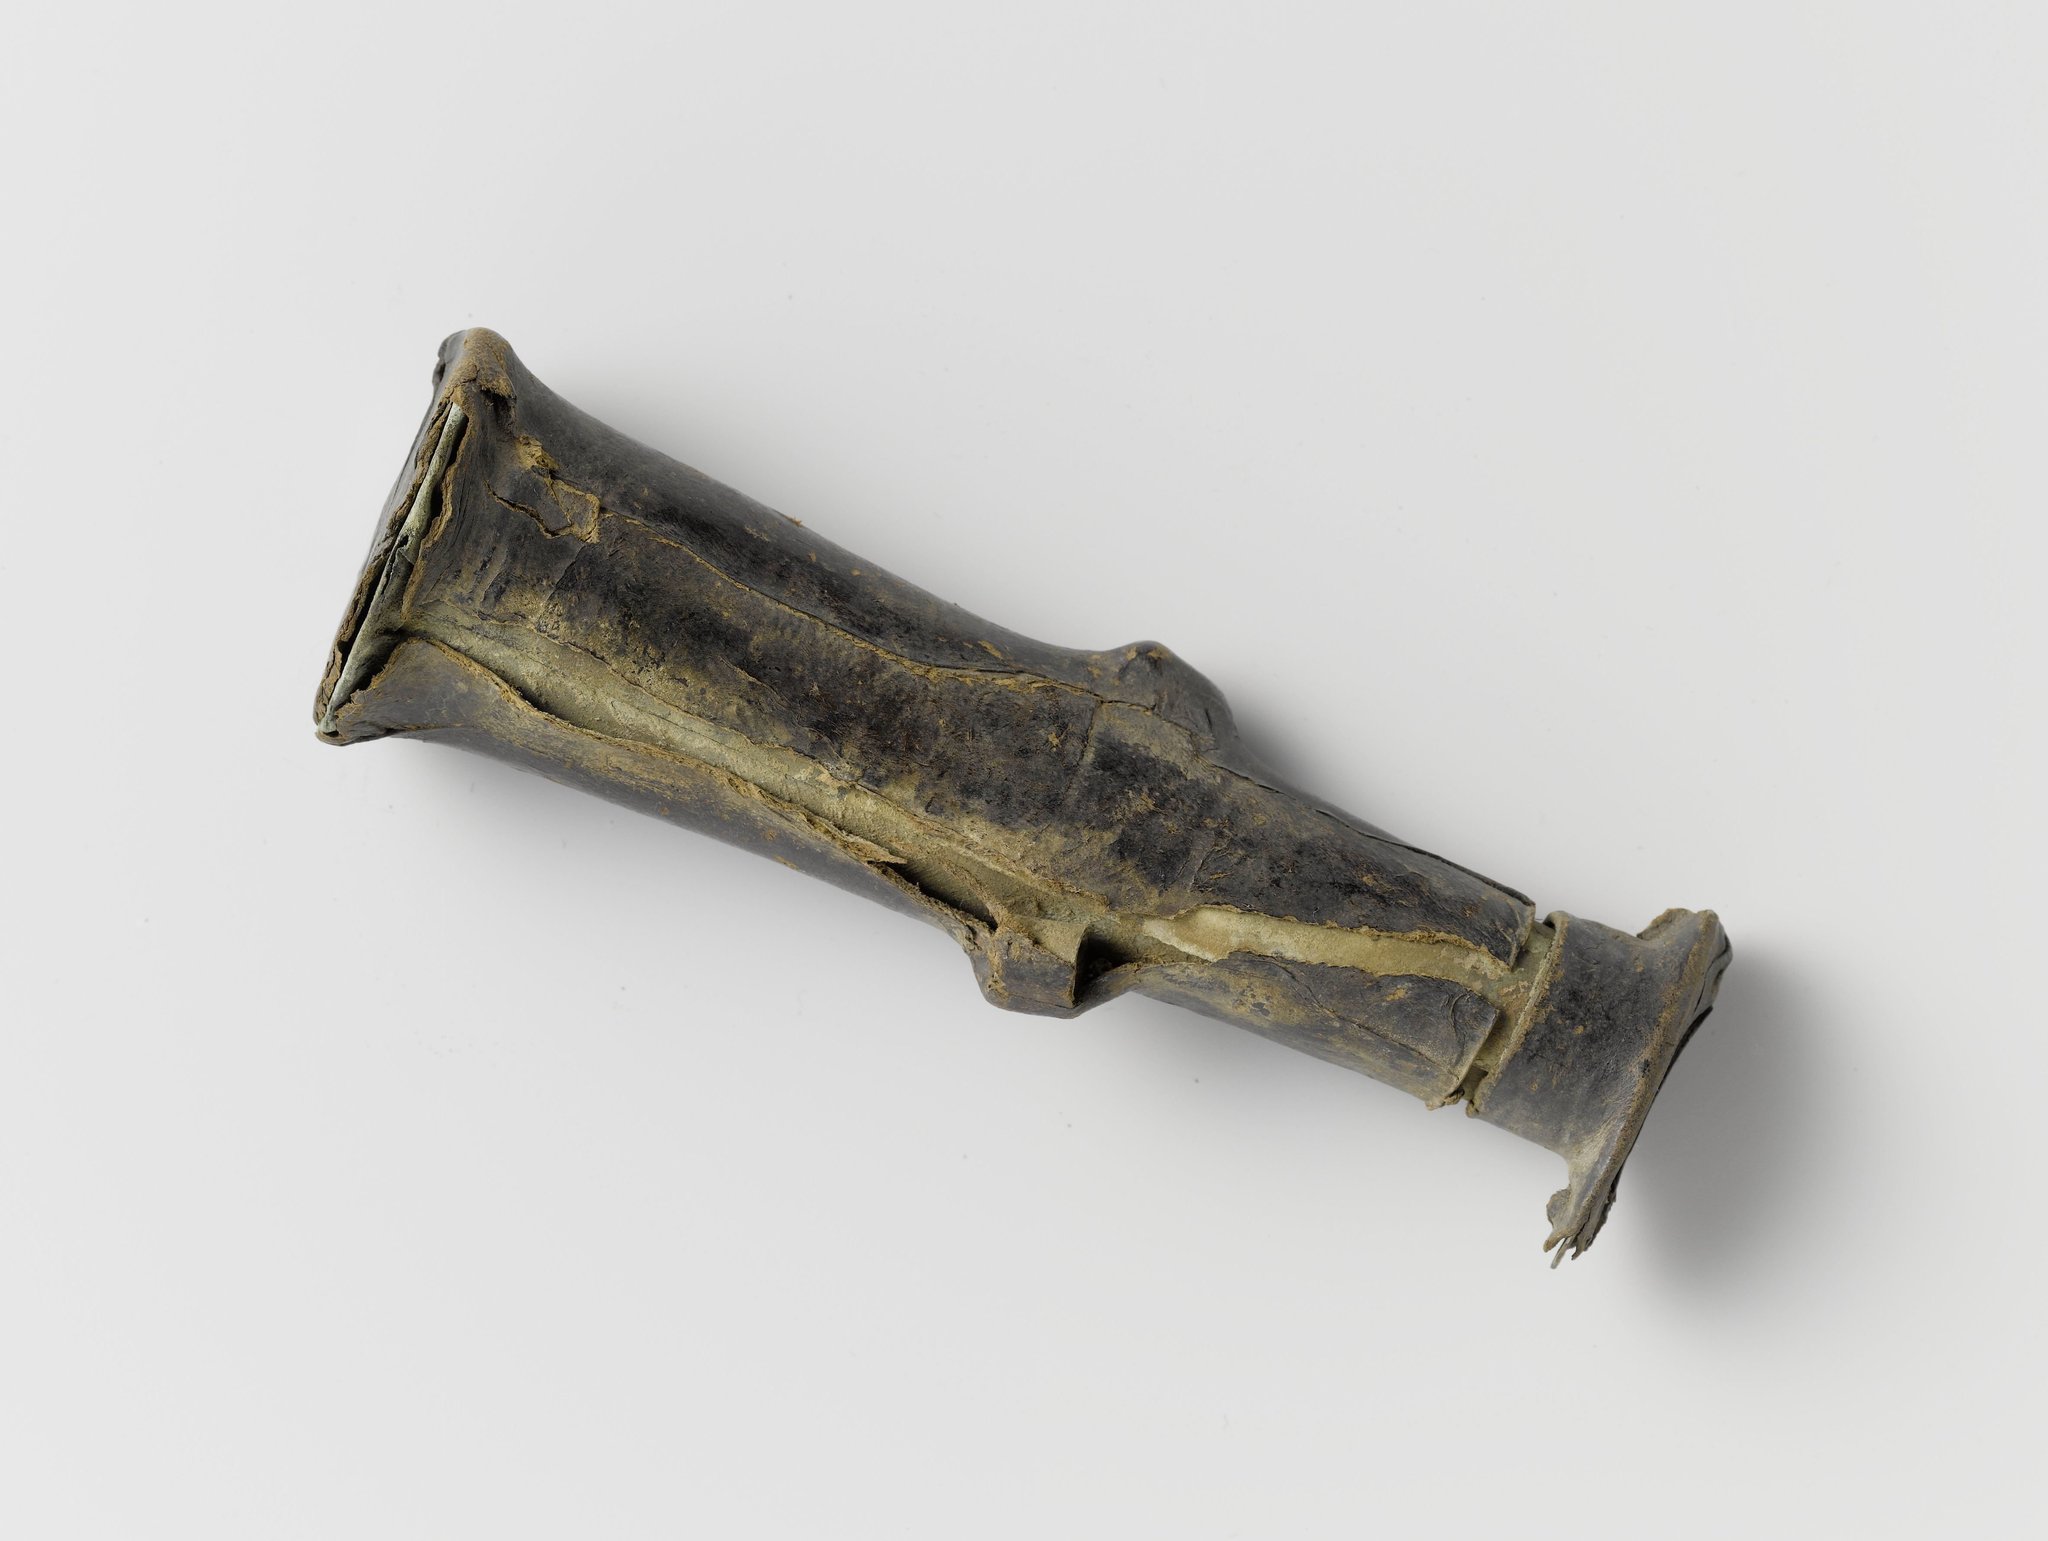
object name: kruitmaat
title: Musketmaat redelijk compleet, alleen de touwtjes ontbreken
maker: Anonymous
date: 1590-1596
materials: brass, leather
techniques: soldering, striking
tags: willem barendsz., amsterdam, jacob van heemskerck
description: Musketmaten dienden om een hoeveelheid buskruit, voldoende voor een schot, mee te dragen. De musketmaten werden twaalf in getal aan een bandelier meegedragen.